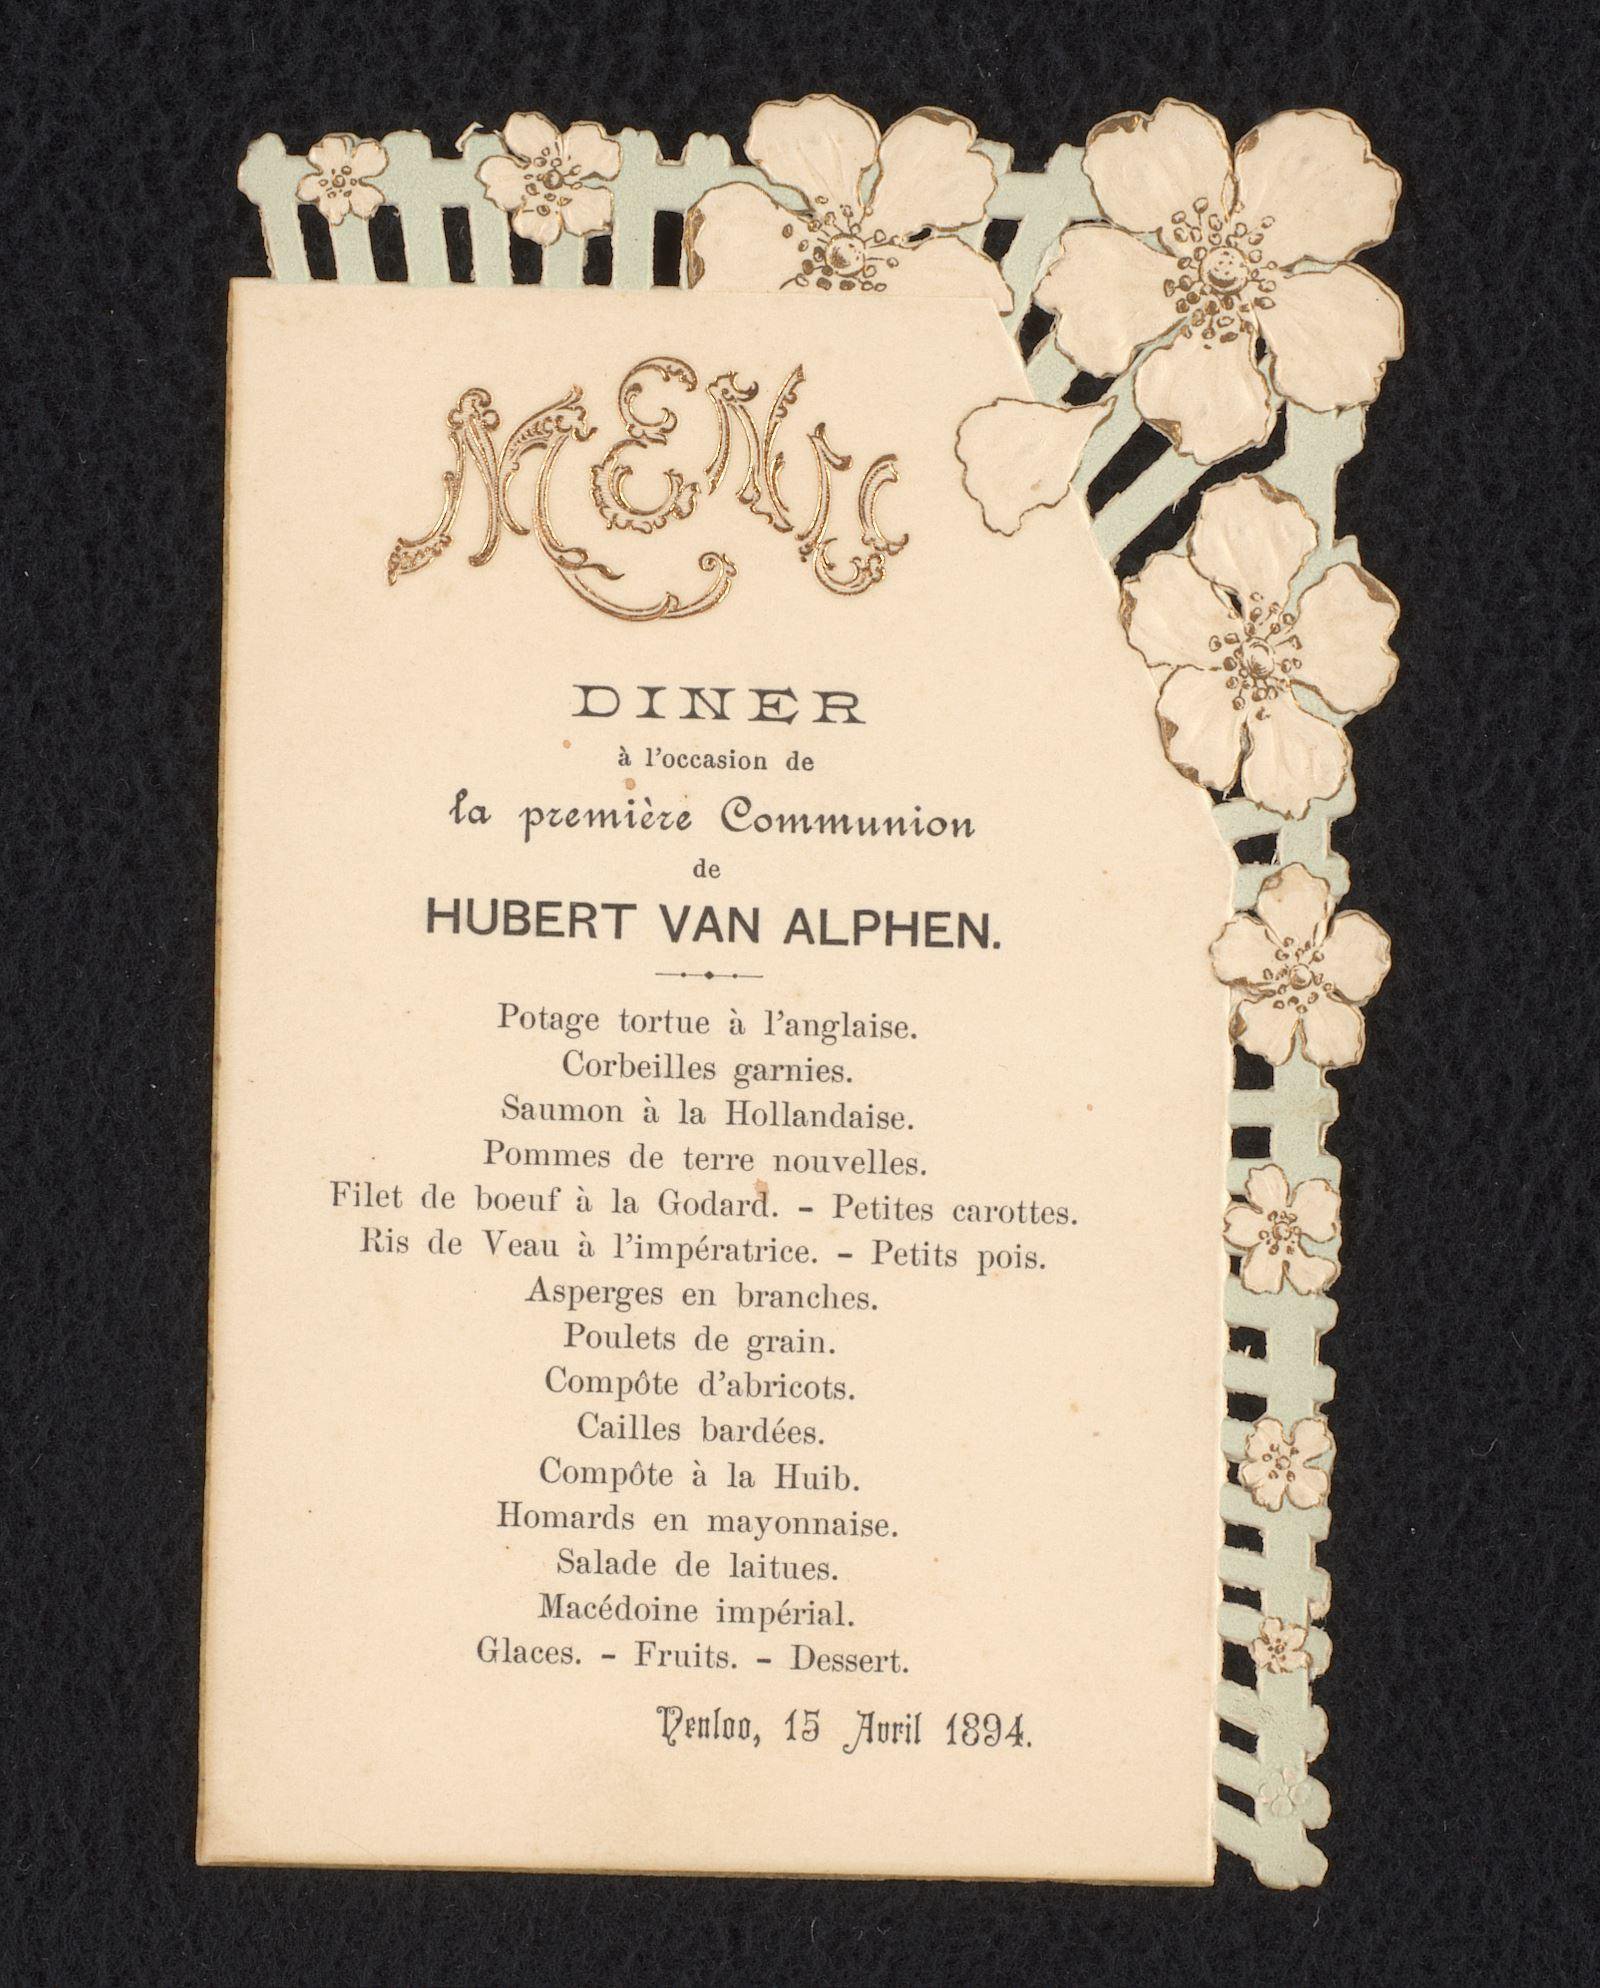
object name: menu, menukaart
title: Menu van het diner ter ere van de eerste heilige communie van Hubert van Alphen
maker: Anonymous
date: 1894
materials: paper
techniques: blind stamped, printing block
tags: flowers, first communion, fence, wall, paling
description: Bij gebrek aan gegevens over de vervaardiger is voor de bepaling van de rechten van dit object gebruik gemaakt van de vervaardigingsdatum.